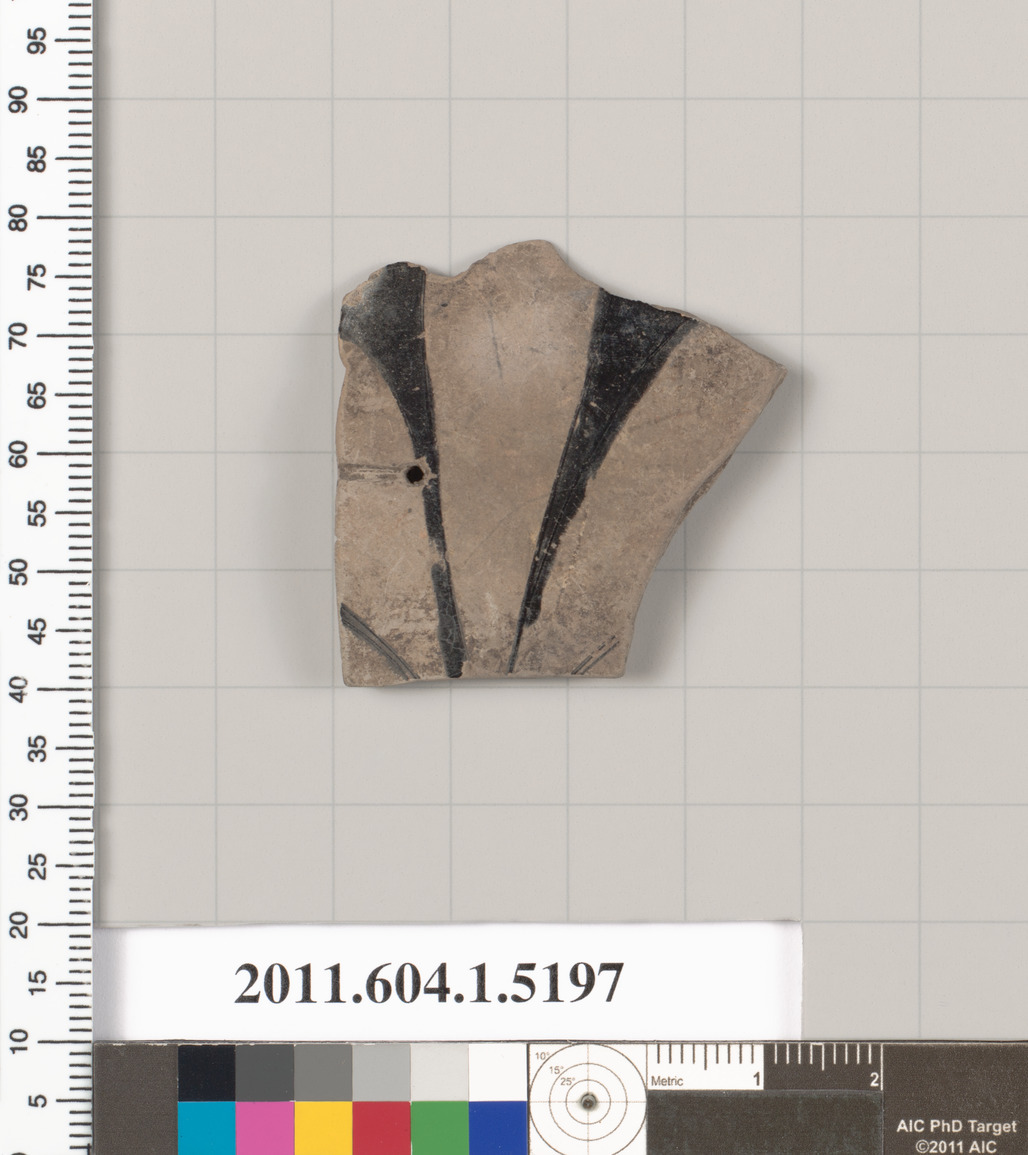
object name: kylix fragment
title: Terracotta fragment of a kylix (drinking cup)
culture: greek, attic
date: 520-510 BCE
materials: terracotta